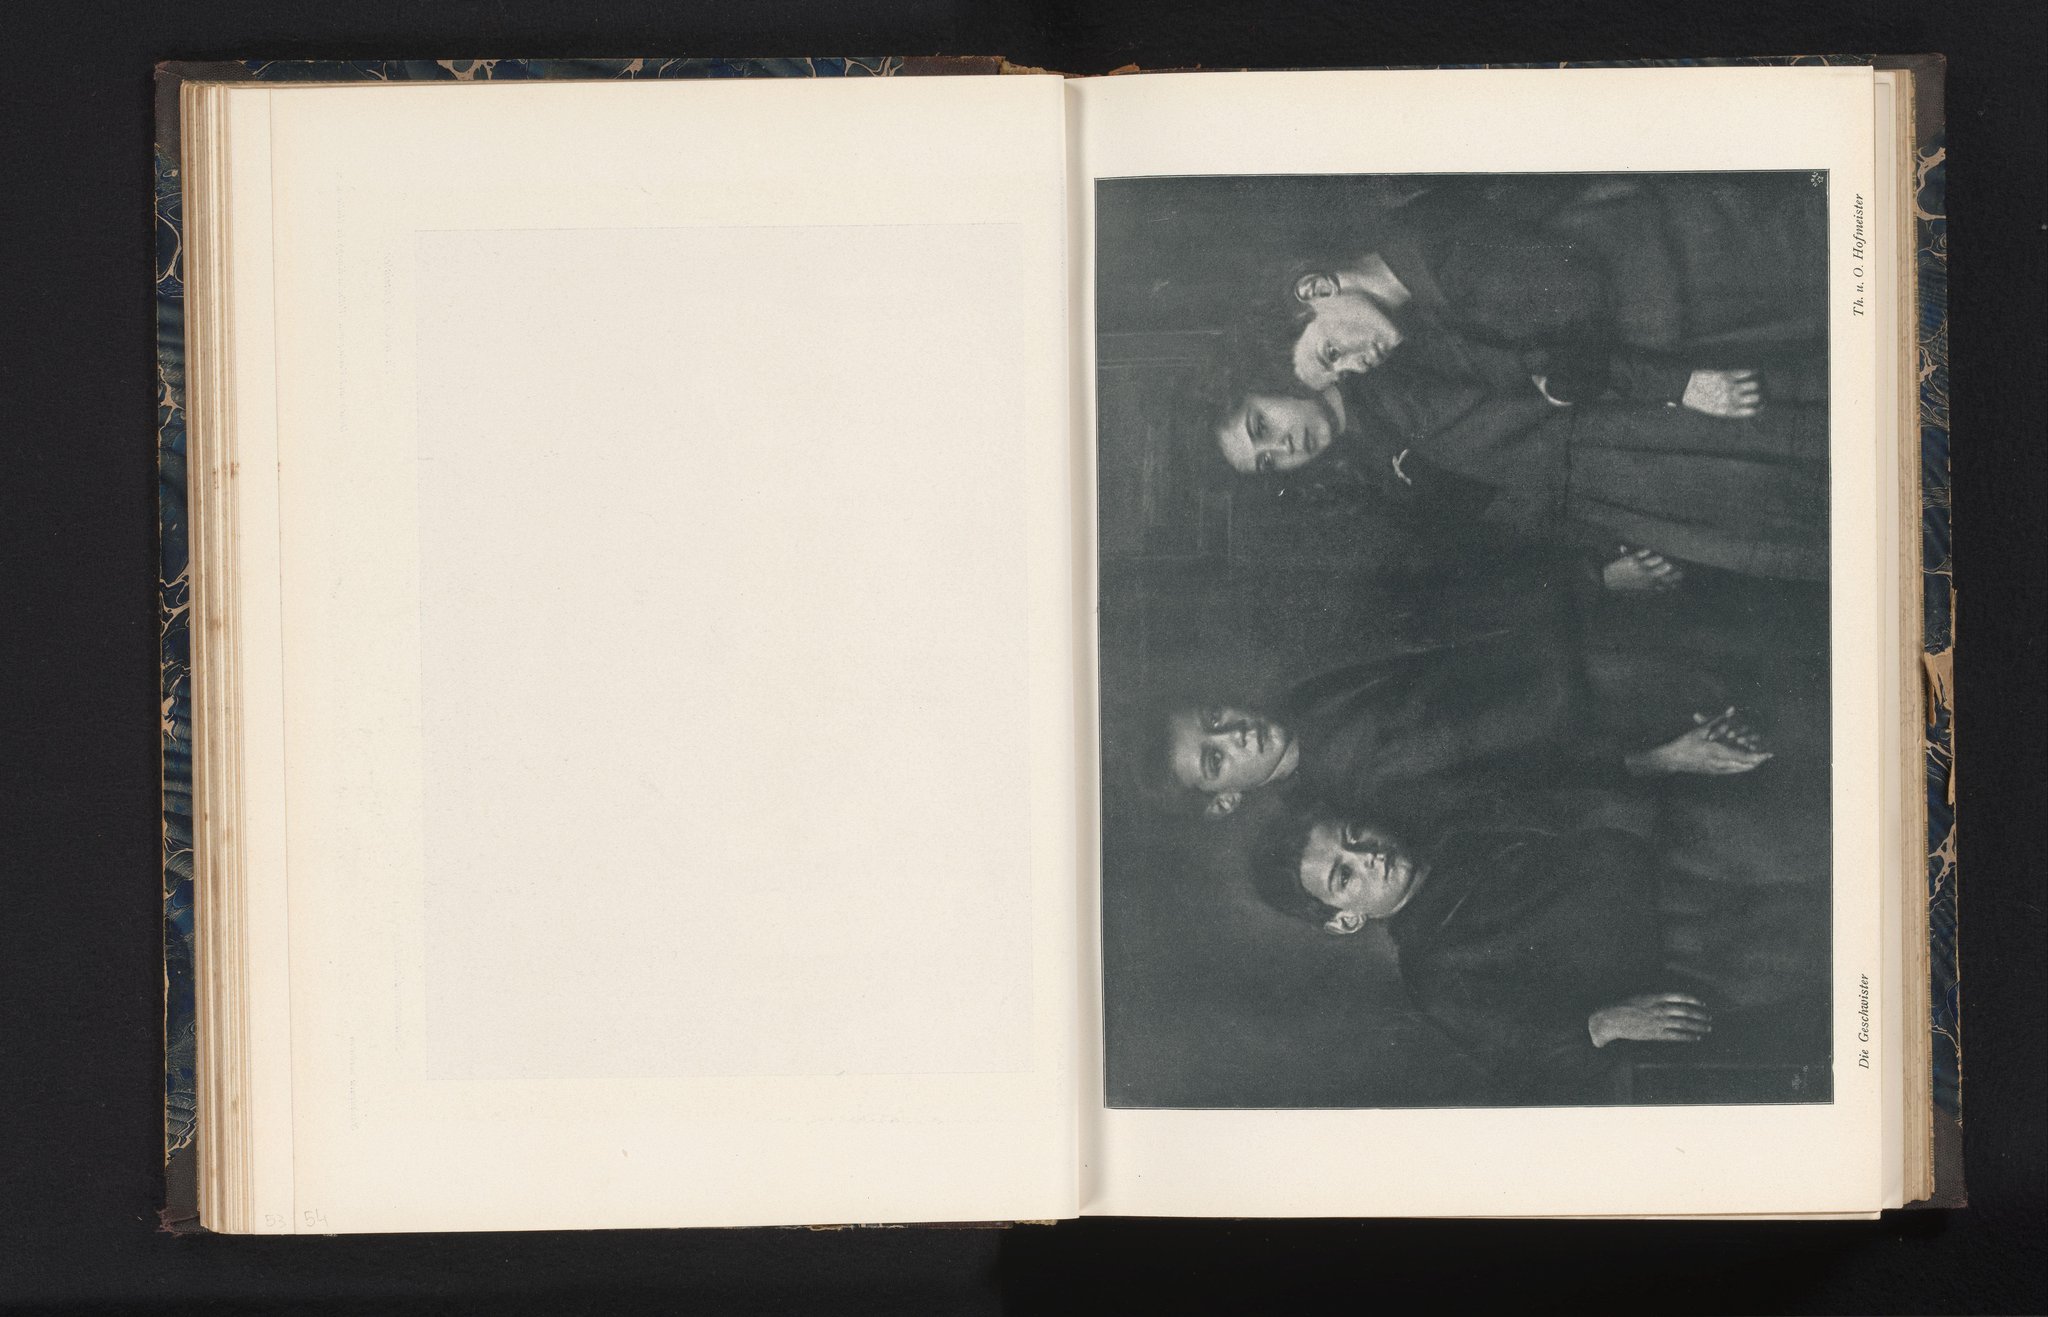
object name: page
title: Groepsportret van vier onbekende kinderen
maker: th. u. o. hofmeister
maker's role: fotograaf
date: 1897-1902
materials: paper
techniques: autotype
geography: berlin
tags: child, anonymous historical persons portrayed in a group, in a group-portrait